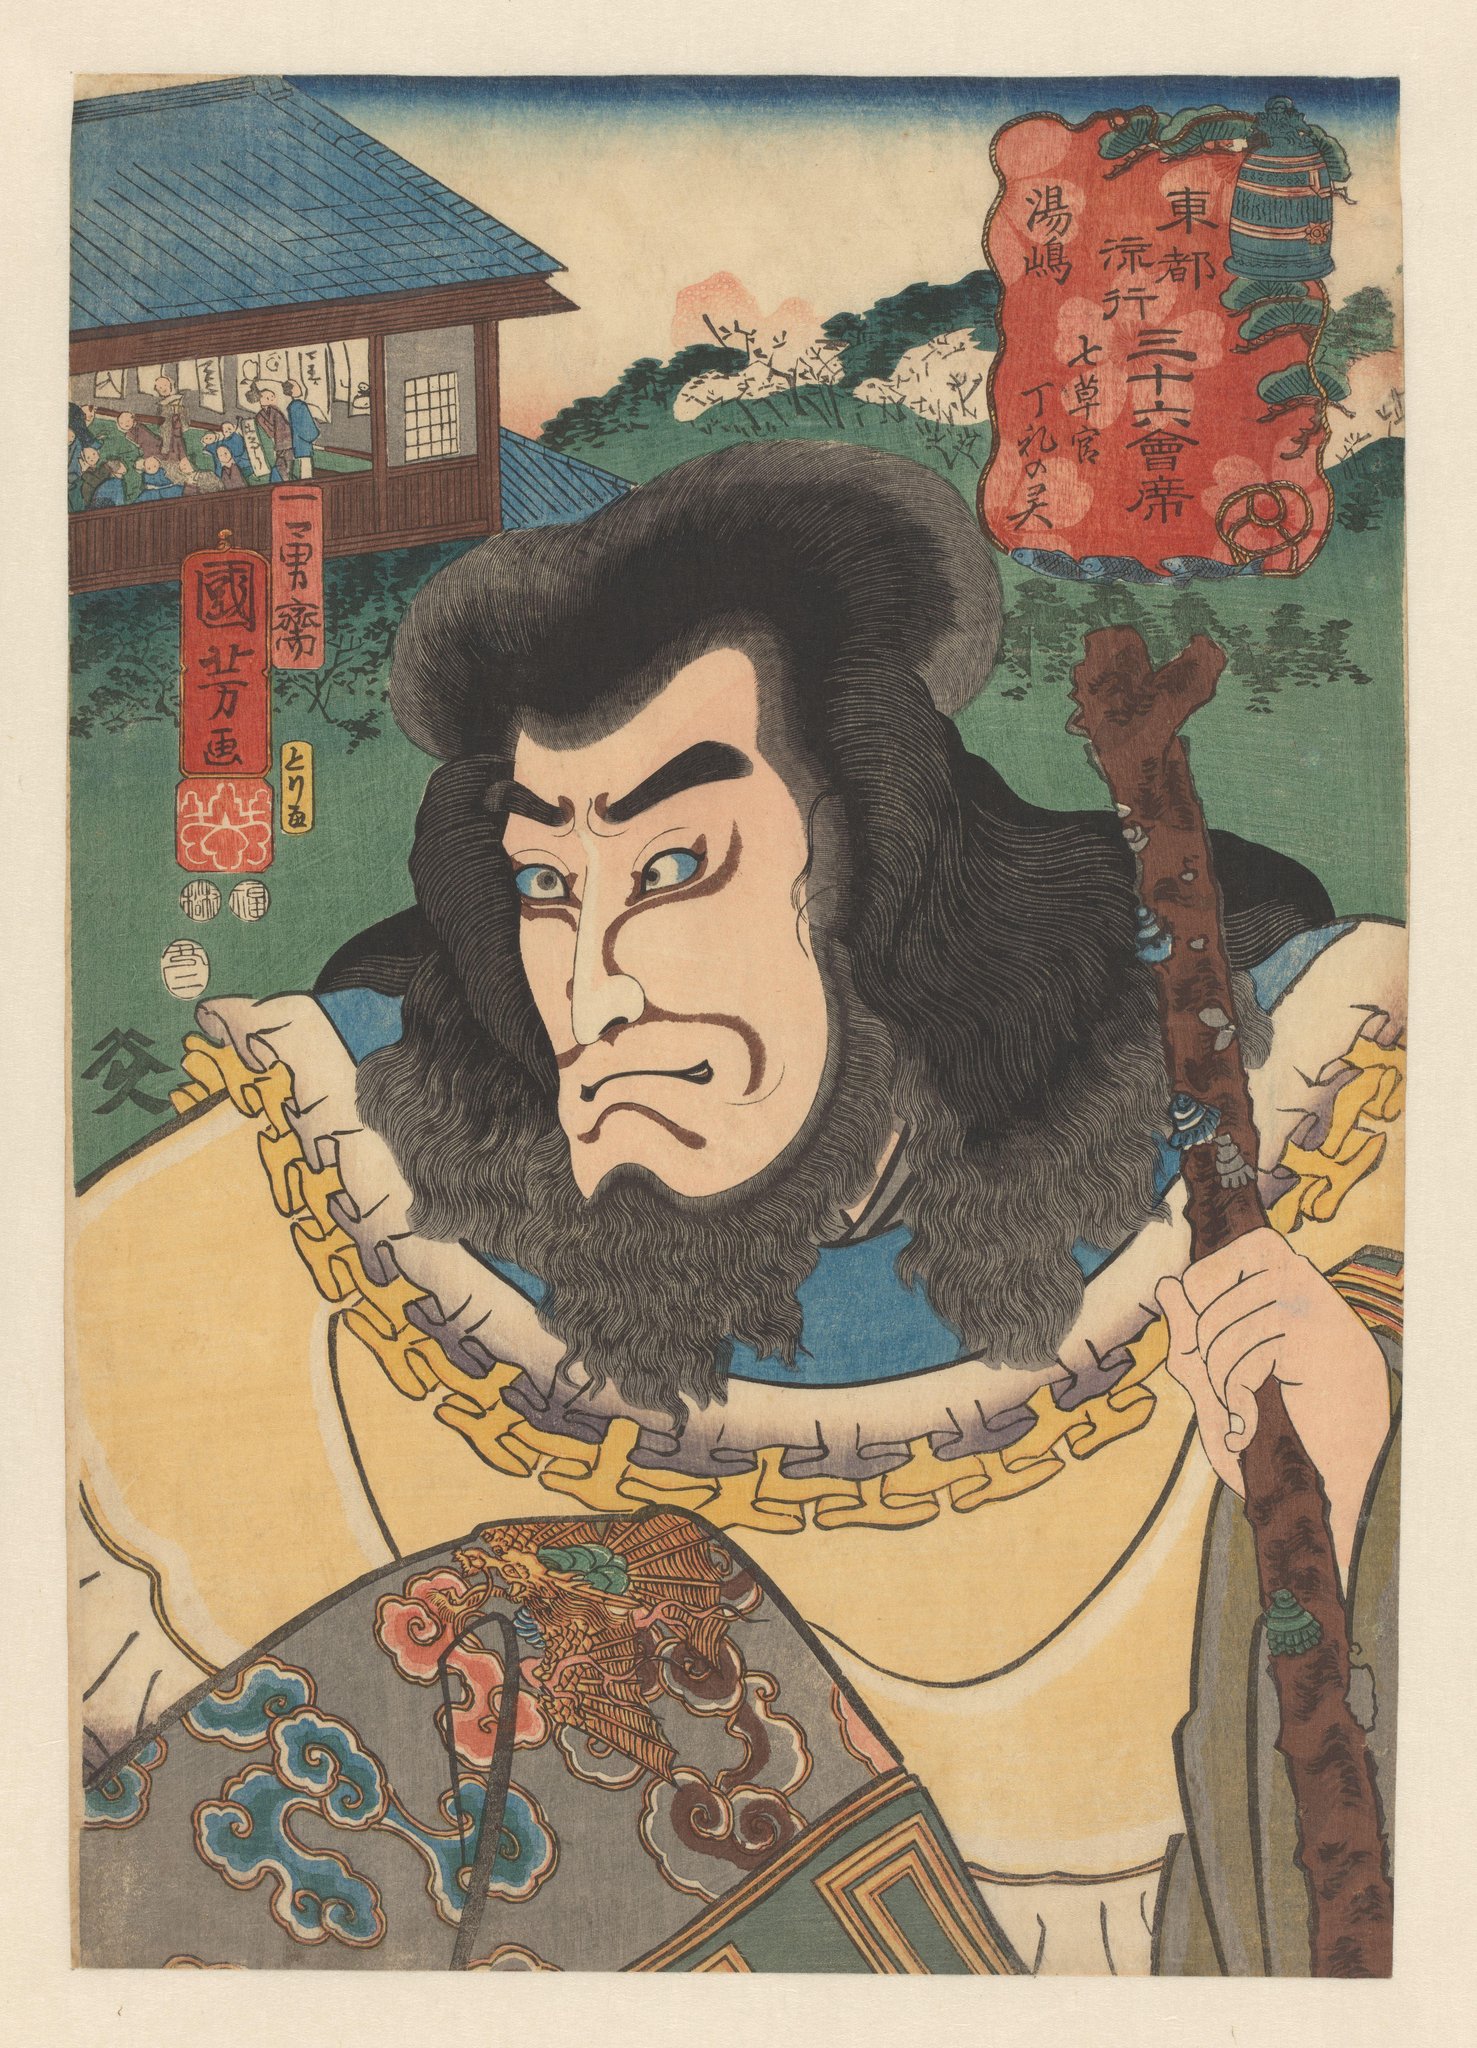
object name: print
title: Yushima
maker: utagawa kuniyoshi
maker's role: draughtsman, print maker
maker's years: 1798-1861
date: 1802-1853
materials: paper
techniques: woodcut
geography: japan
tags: walking-stick, staff, adult man, housing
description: Het spook Nanakusa kan Chohan met wandelstok in geel tenue met in zijn hand een grote wandelstok. Op de achtergrond het populaire restaurant Yushima in Edo.